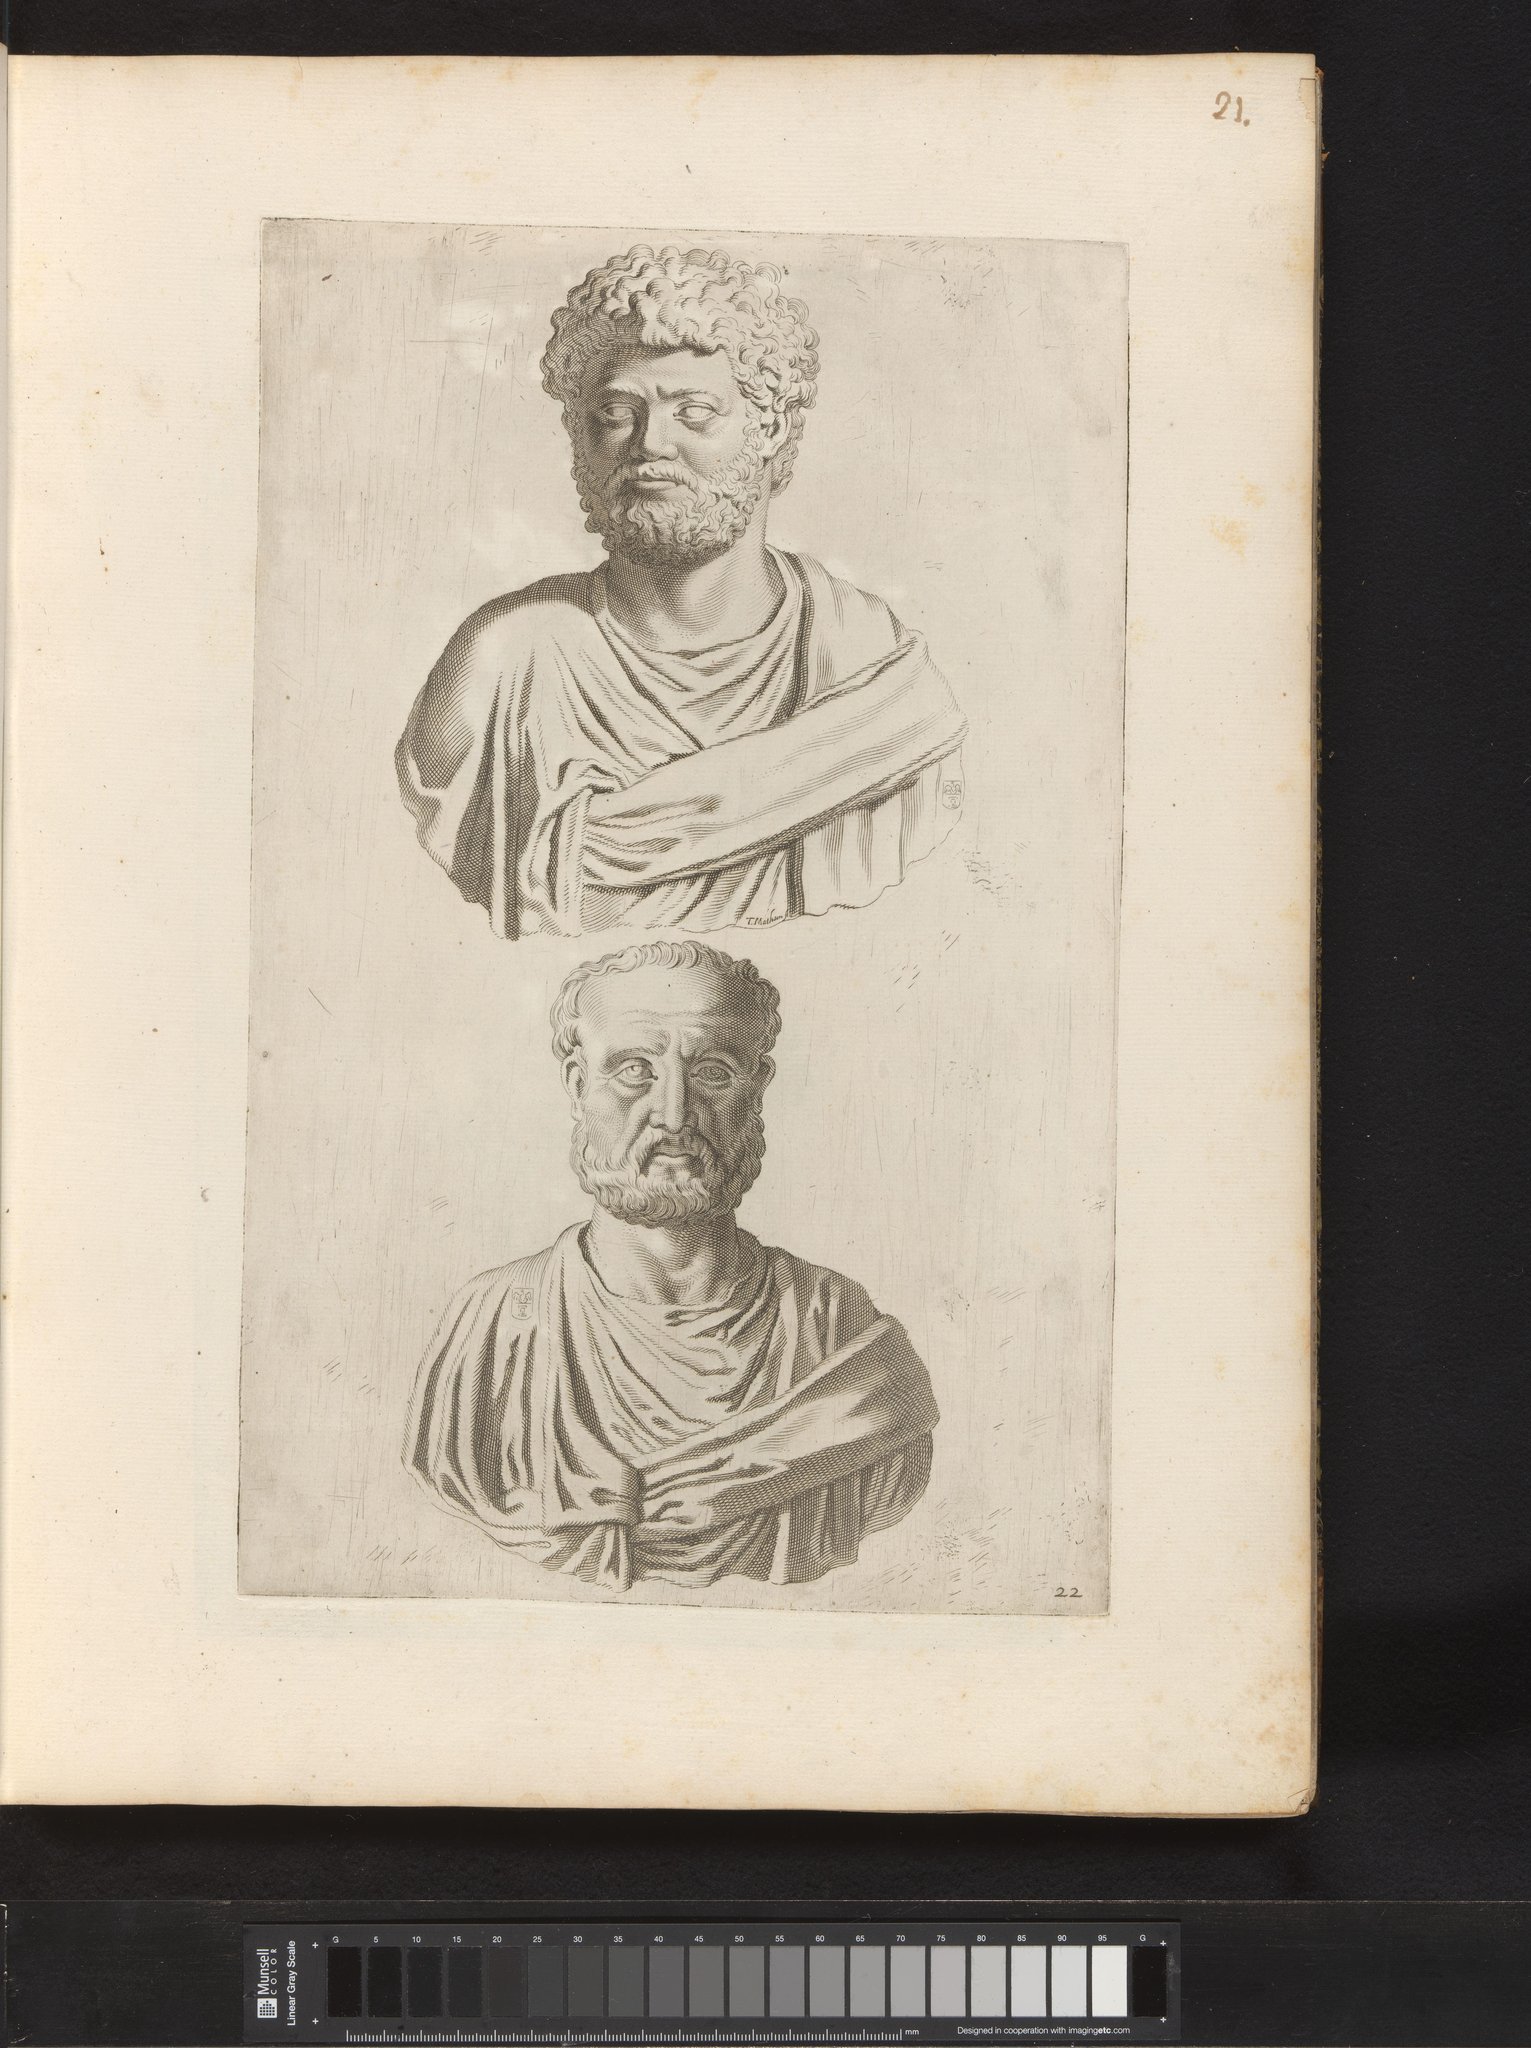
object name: album leaf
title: Galleria Giustiniana del Marchese Vincenzo Giustiniani II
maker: reinier van persijn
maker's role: draughtsman, painter, print maker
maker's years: 1614-1668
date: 1636-1647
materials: paper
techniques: engraving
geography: rome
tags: miseno, male persons from classical history (+ head, bust, etc.), piece of sculpture, reproduction of a piece of sculpture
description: Twee Romeinse portretbustes van keizer Domitianus en keizer Tiberius. In het midden het wapenschild van Vincenzo Giustiniani. Prent maakt deel uit van een album met een serie prenten naar de sculpturen in de verzameling in de Galleria Giustiniani te Rome.